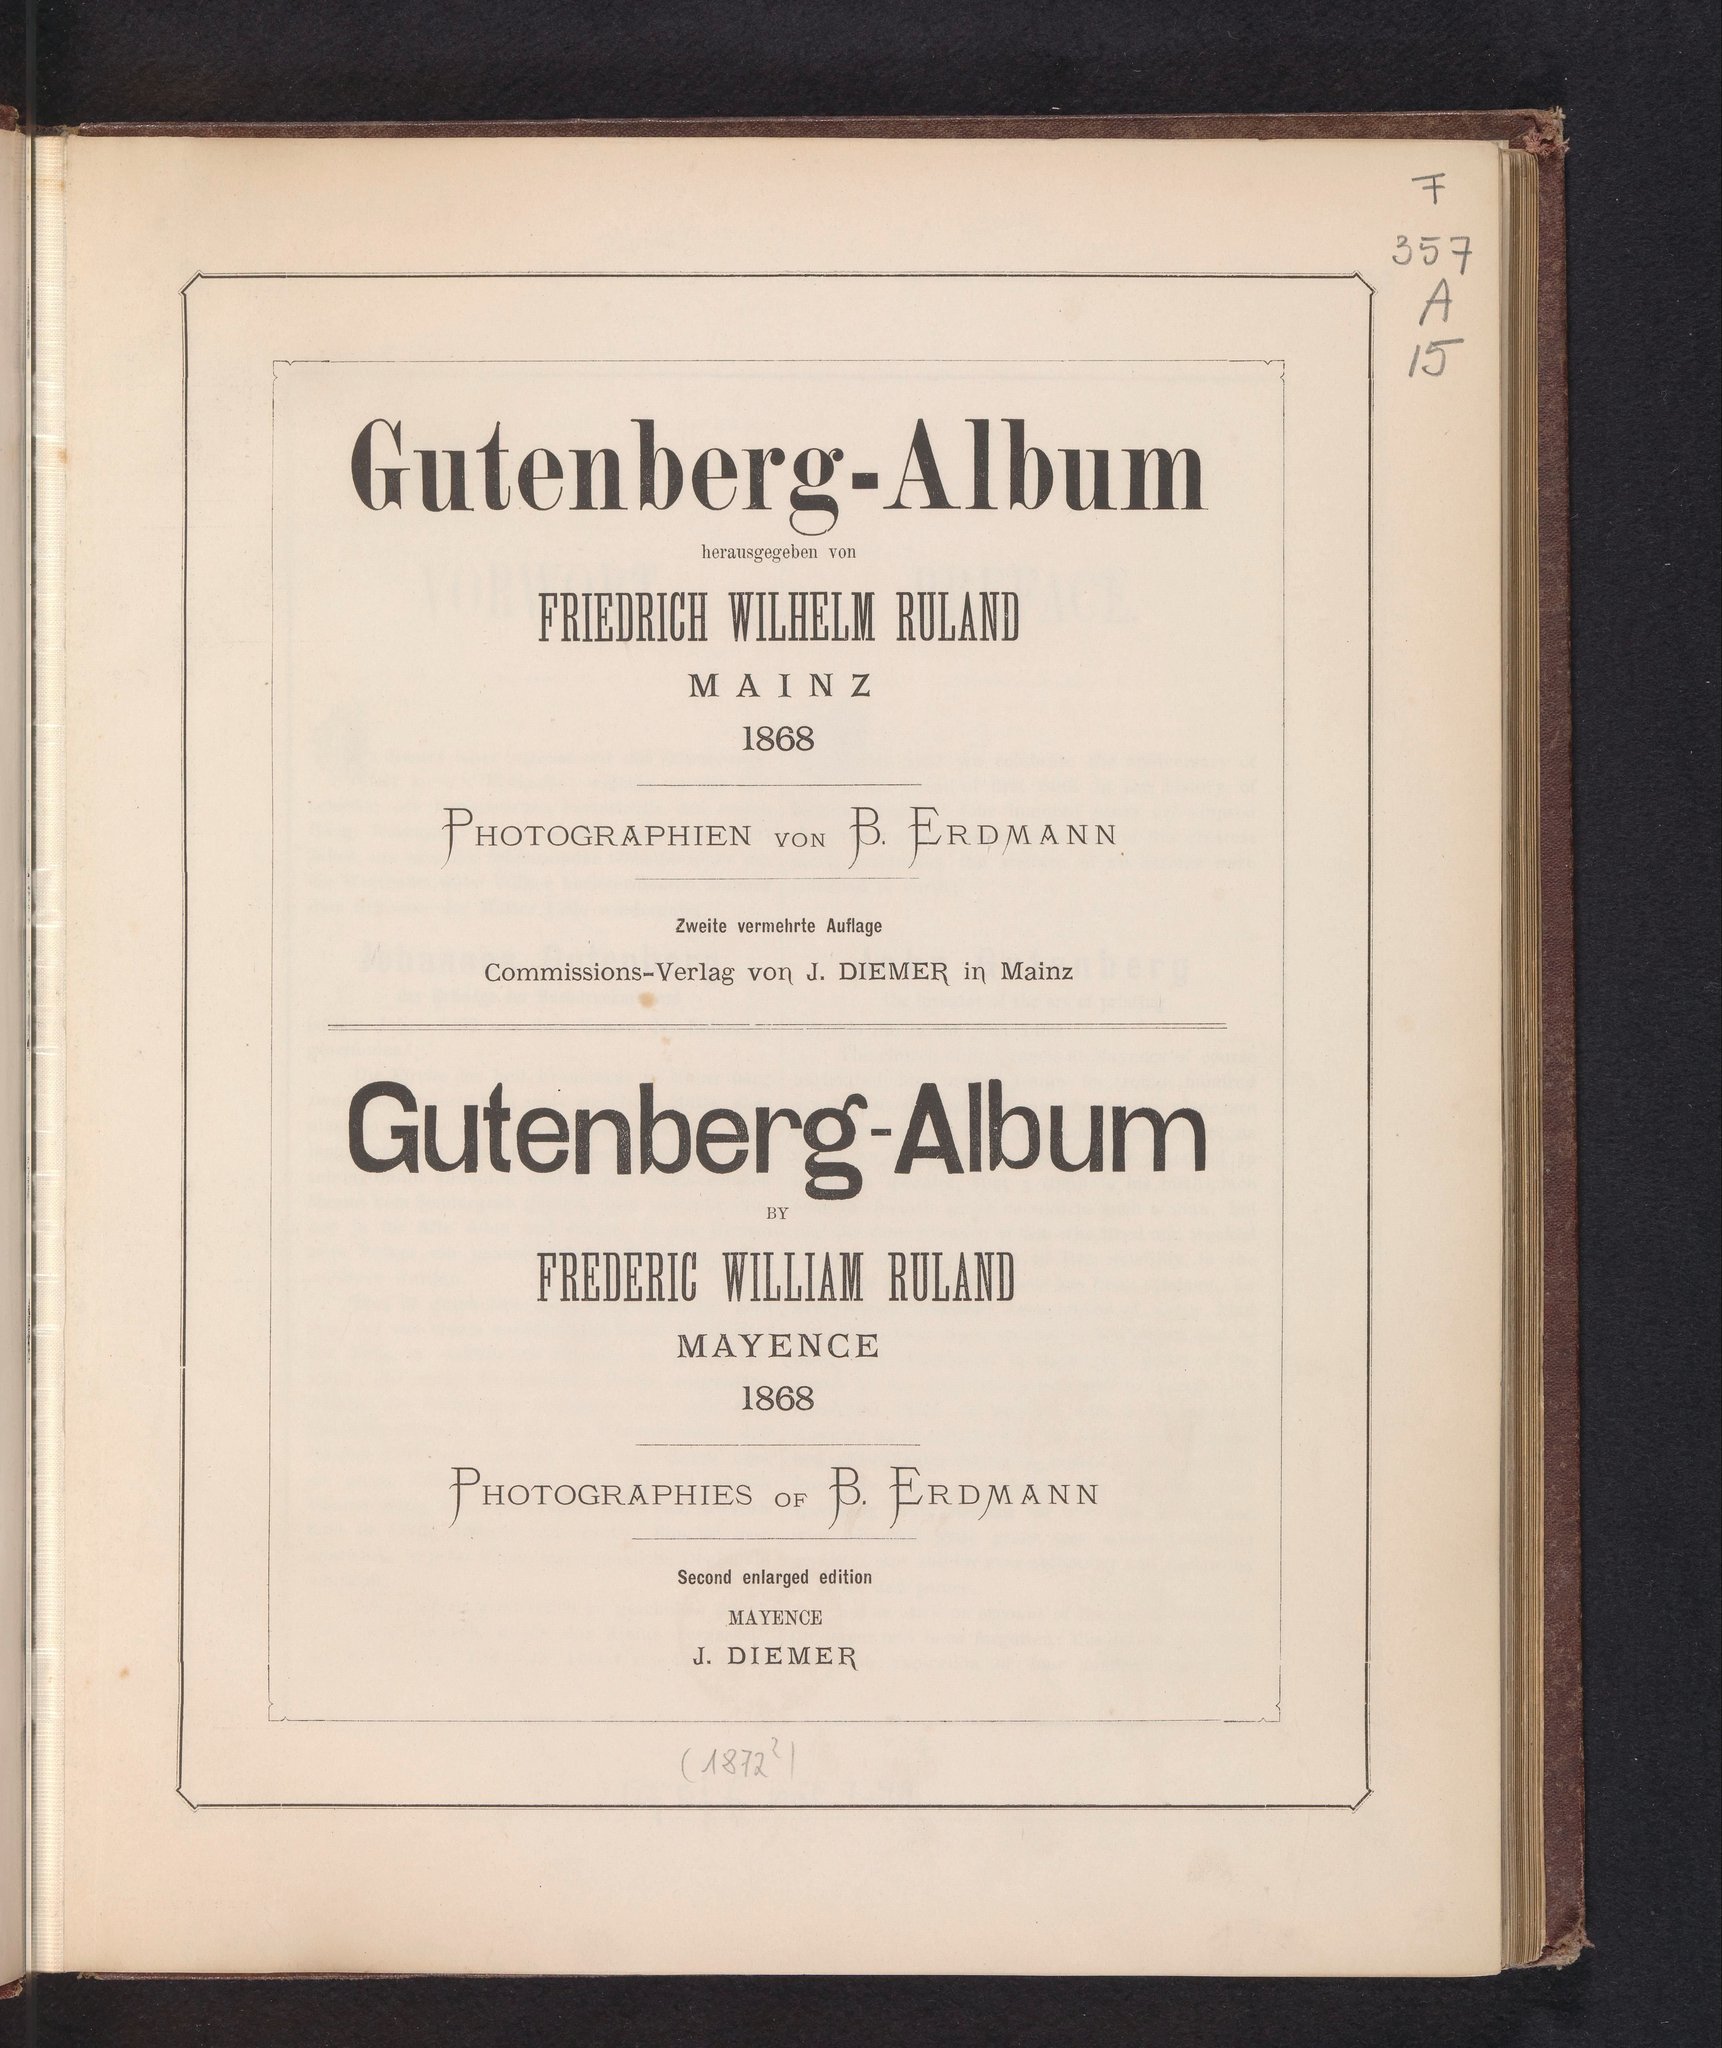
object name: book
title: Gutenberg-Album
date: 1872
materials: cardboard, linen, paper, photographic support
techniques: albumen print, printing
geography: mainz